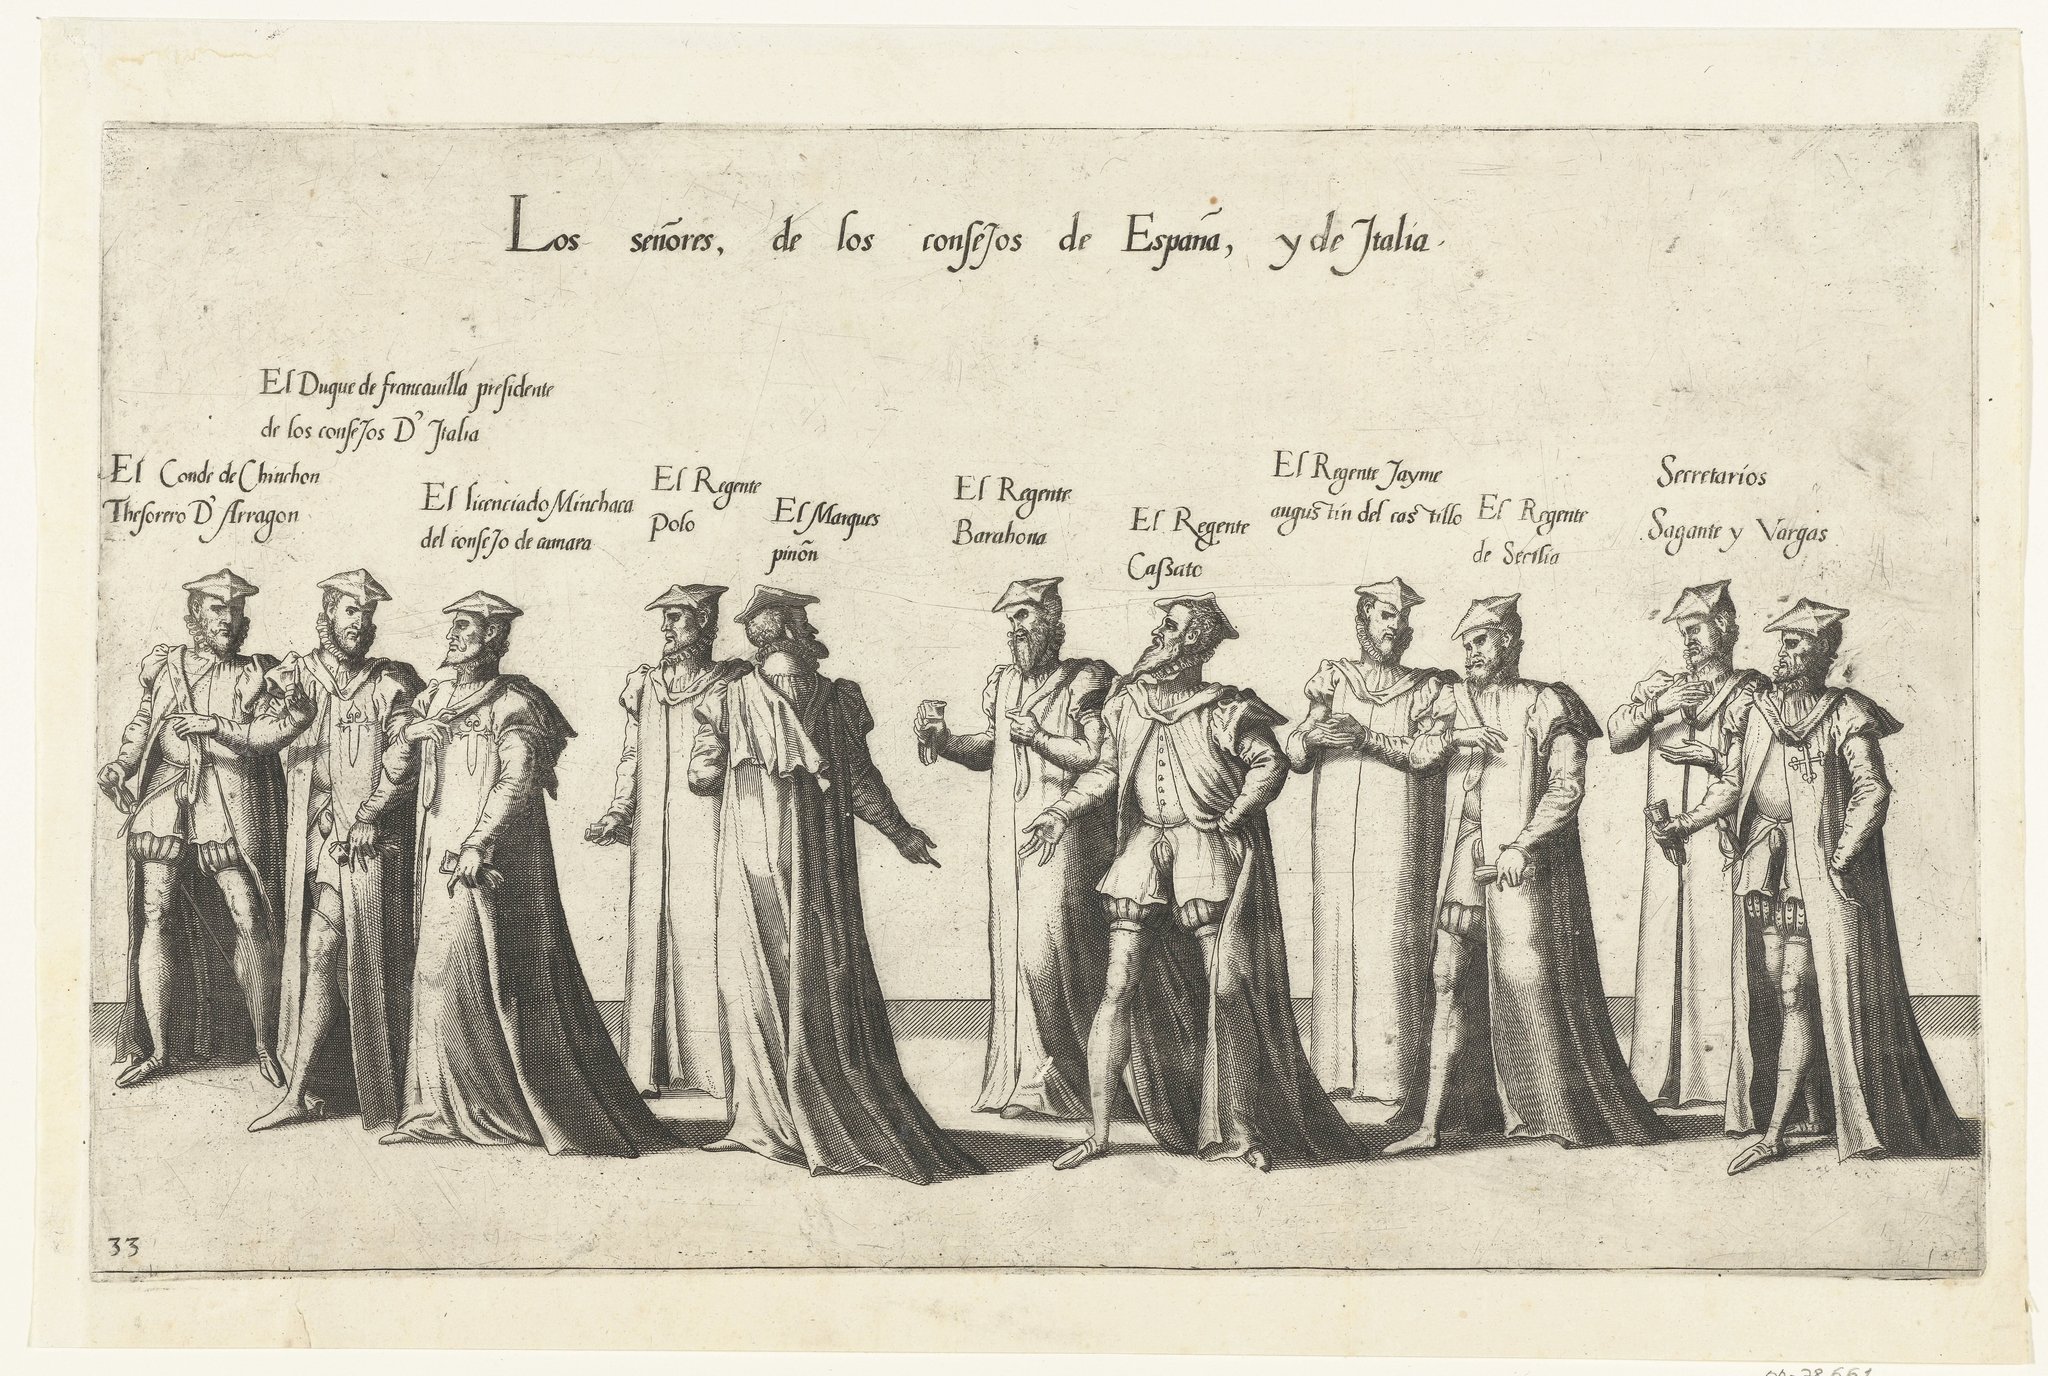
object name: print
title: Leden van Spaanse en Italiaanse raden, nr. 33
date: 1559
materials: paper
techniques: engraving, etching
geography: southern netherlands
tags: ghent, charles v (holy roman emperor and king of spain), cortege, funeral procession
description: Leden van Spaanse en Italiaanse raden. Onderdeel van de prentreeks van de Begrafenisoptocht van keizer Karel V op 29 december 1558 te Brussel.